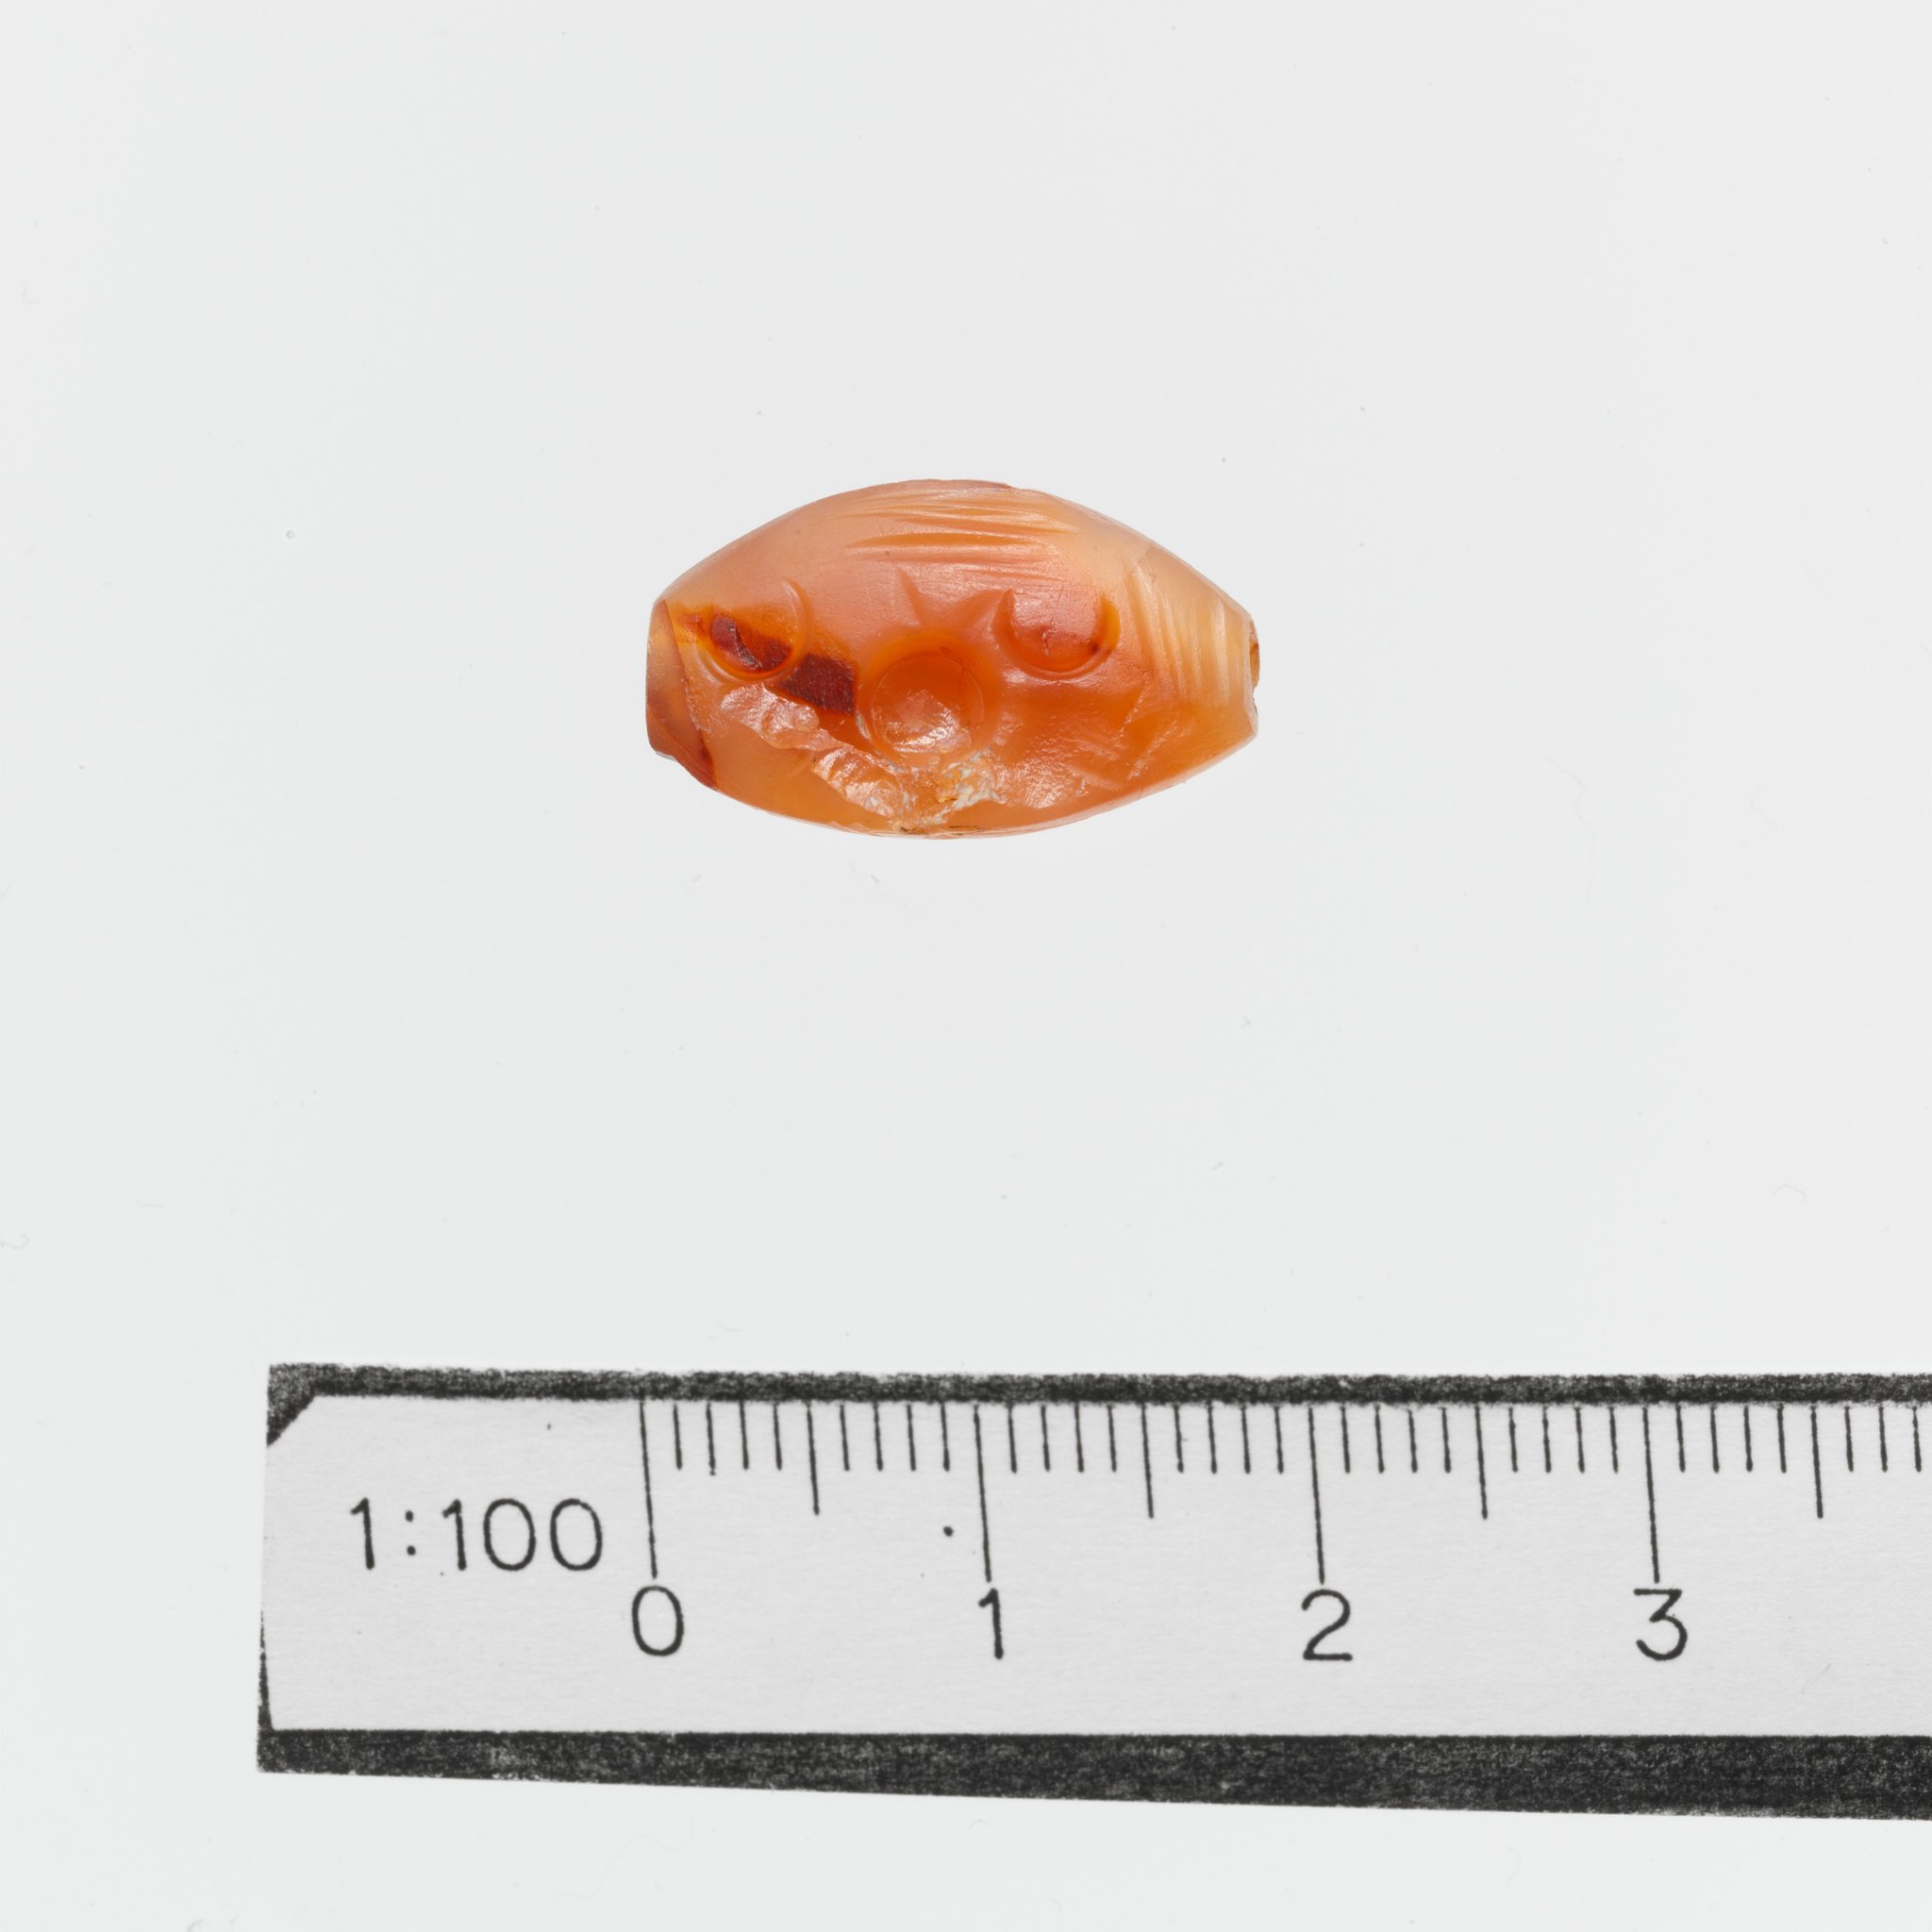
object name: seal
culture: minoan, crete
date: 2000-1450 BCE